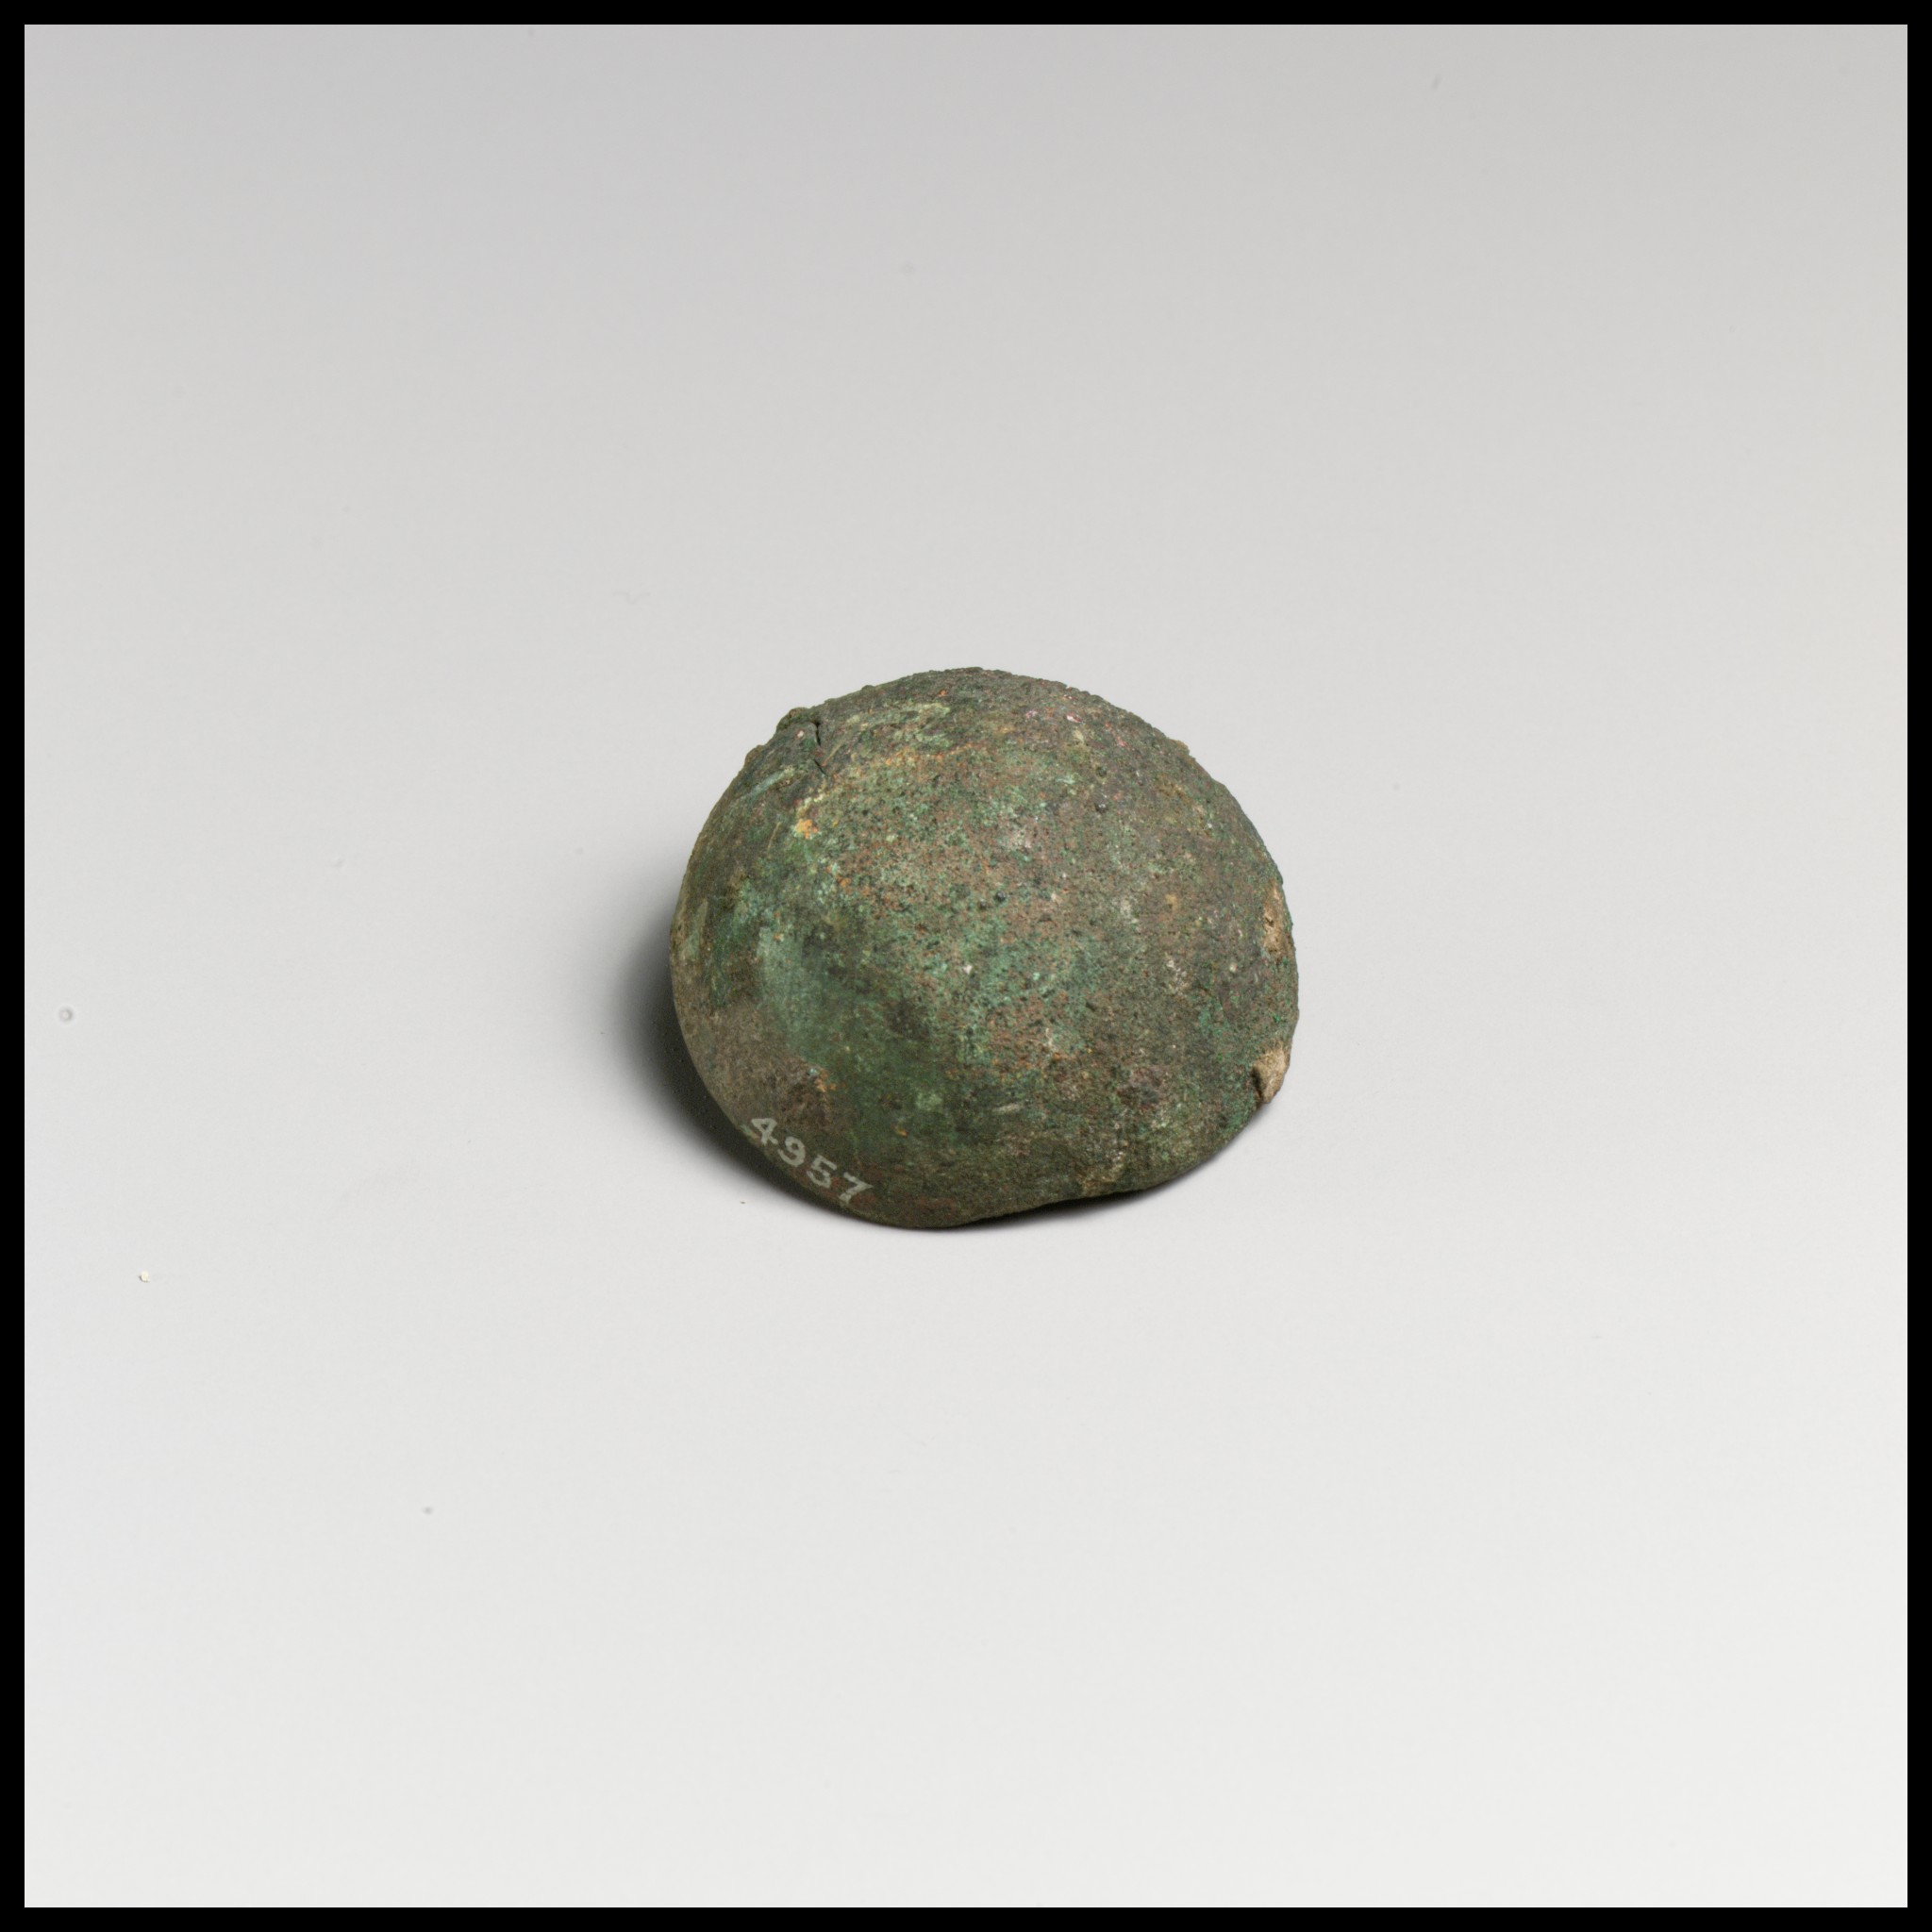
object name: shield bos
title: Shield boss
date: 7000 BCE-330 CE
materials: bronze